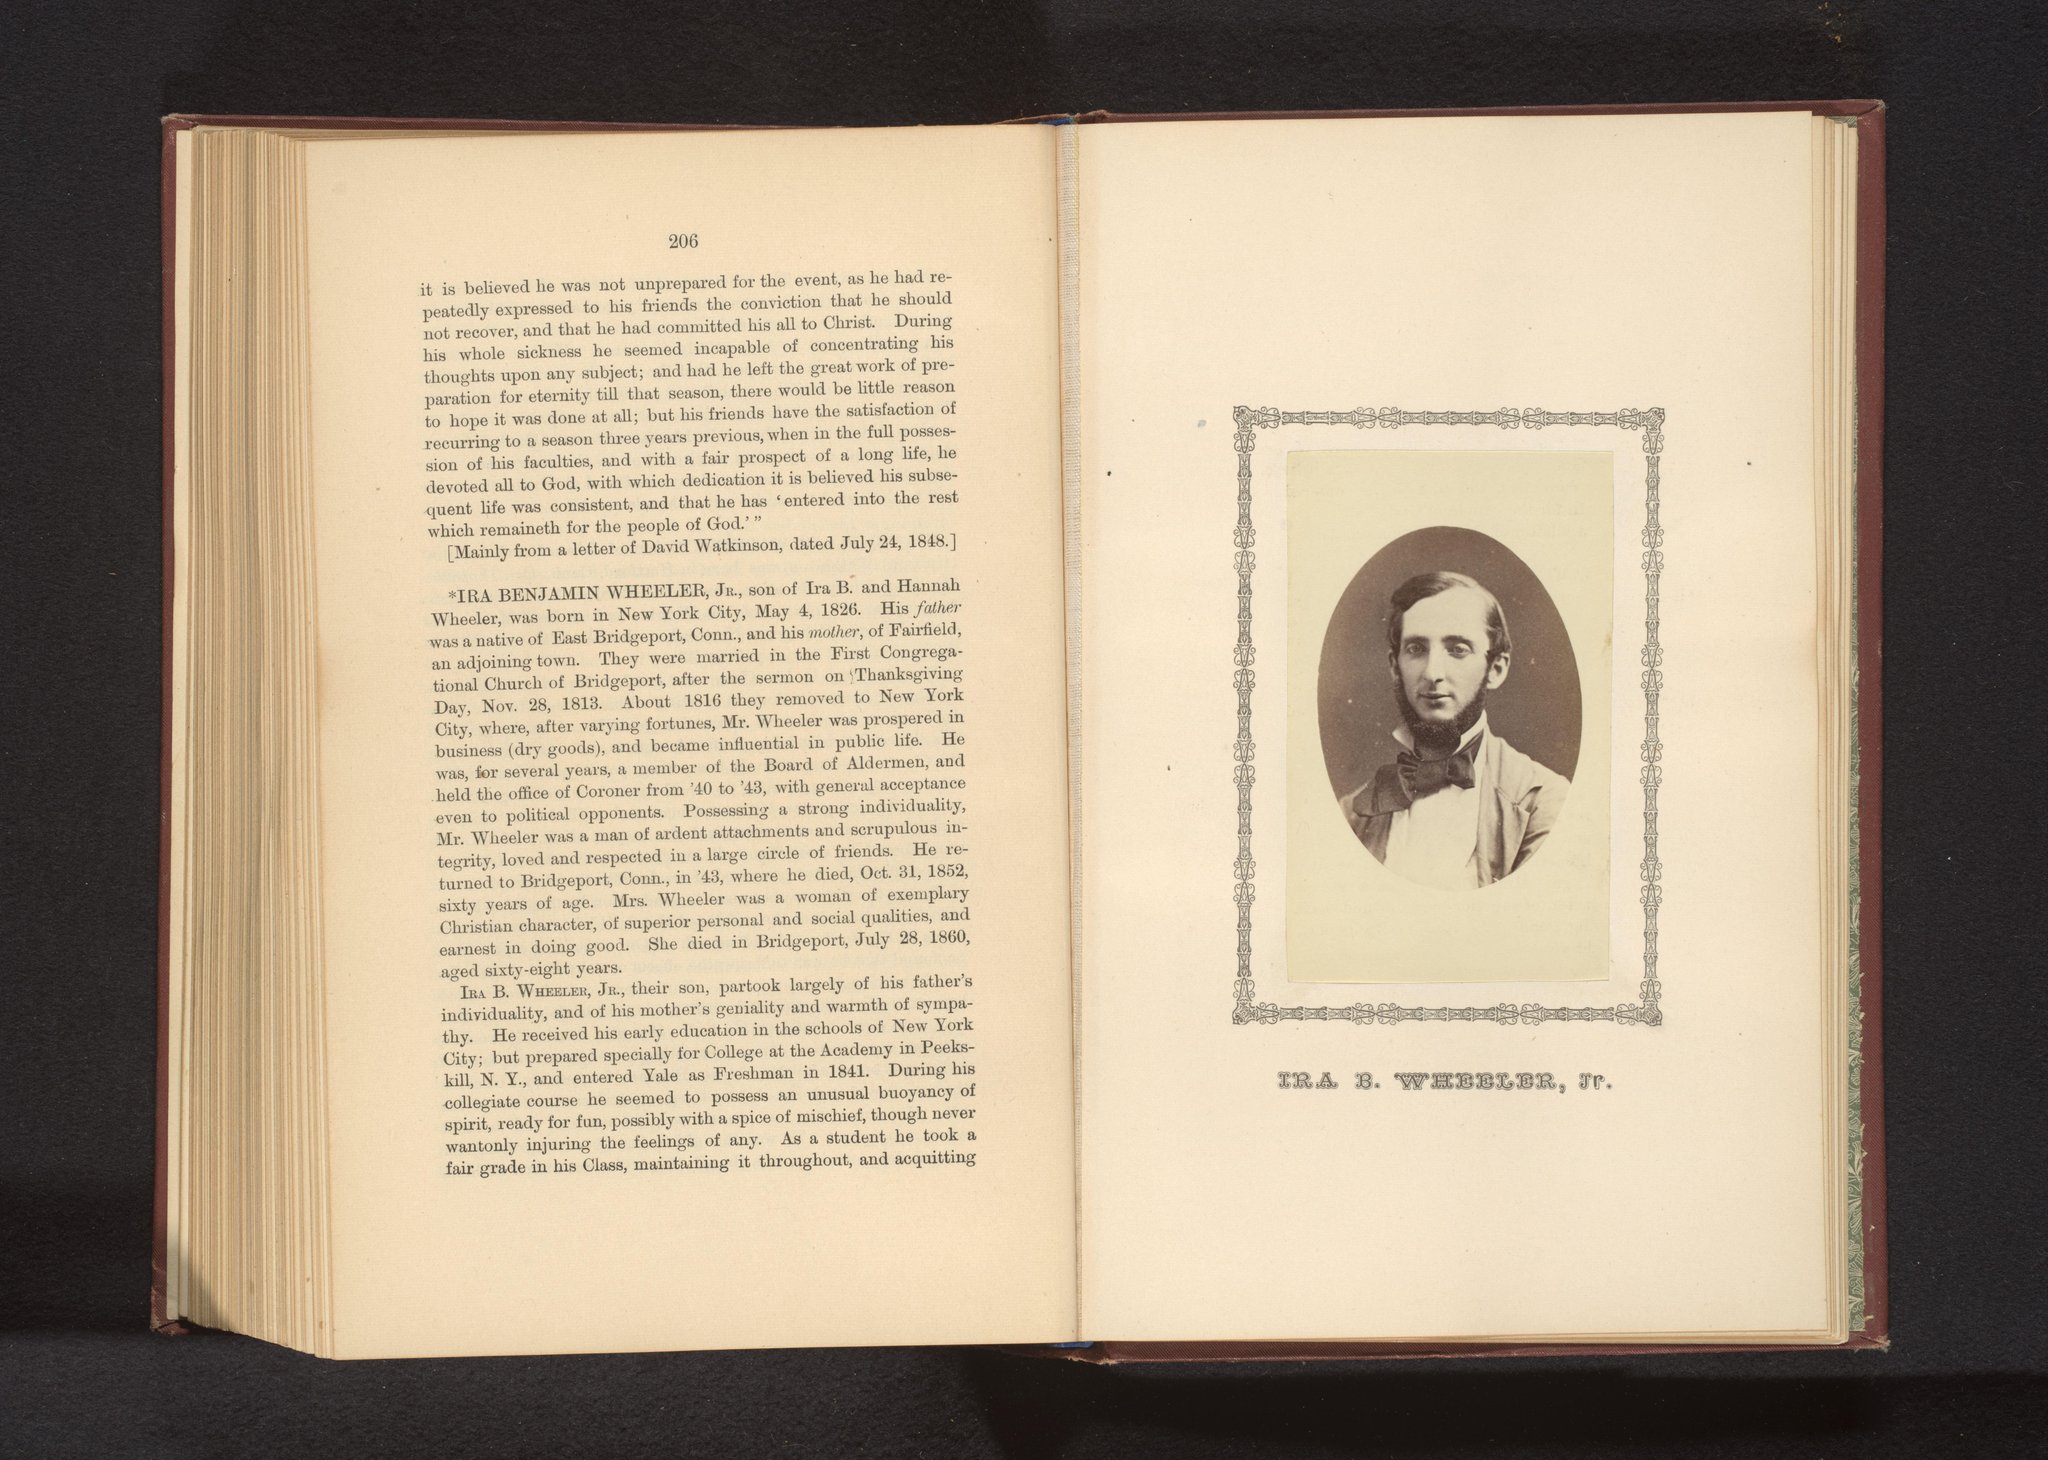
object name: page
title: Ira B. Wheeler, Jr.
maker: Anonymous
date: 1876-1881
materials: photographic support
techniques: albumen print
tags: adult man